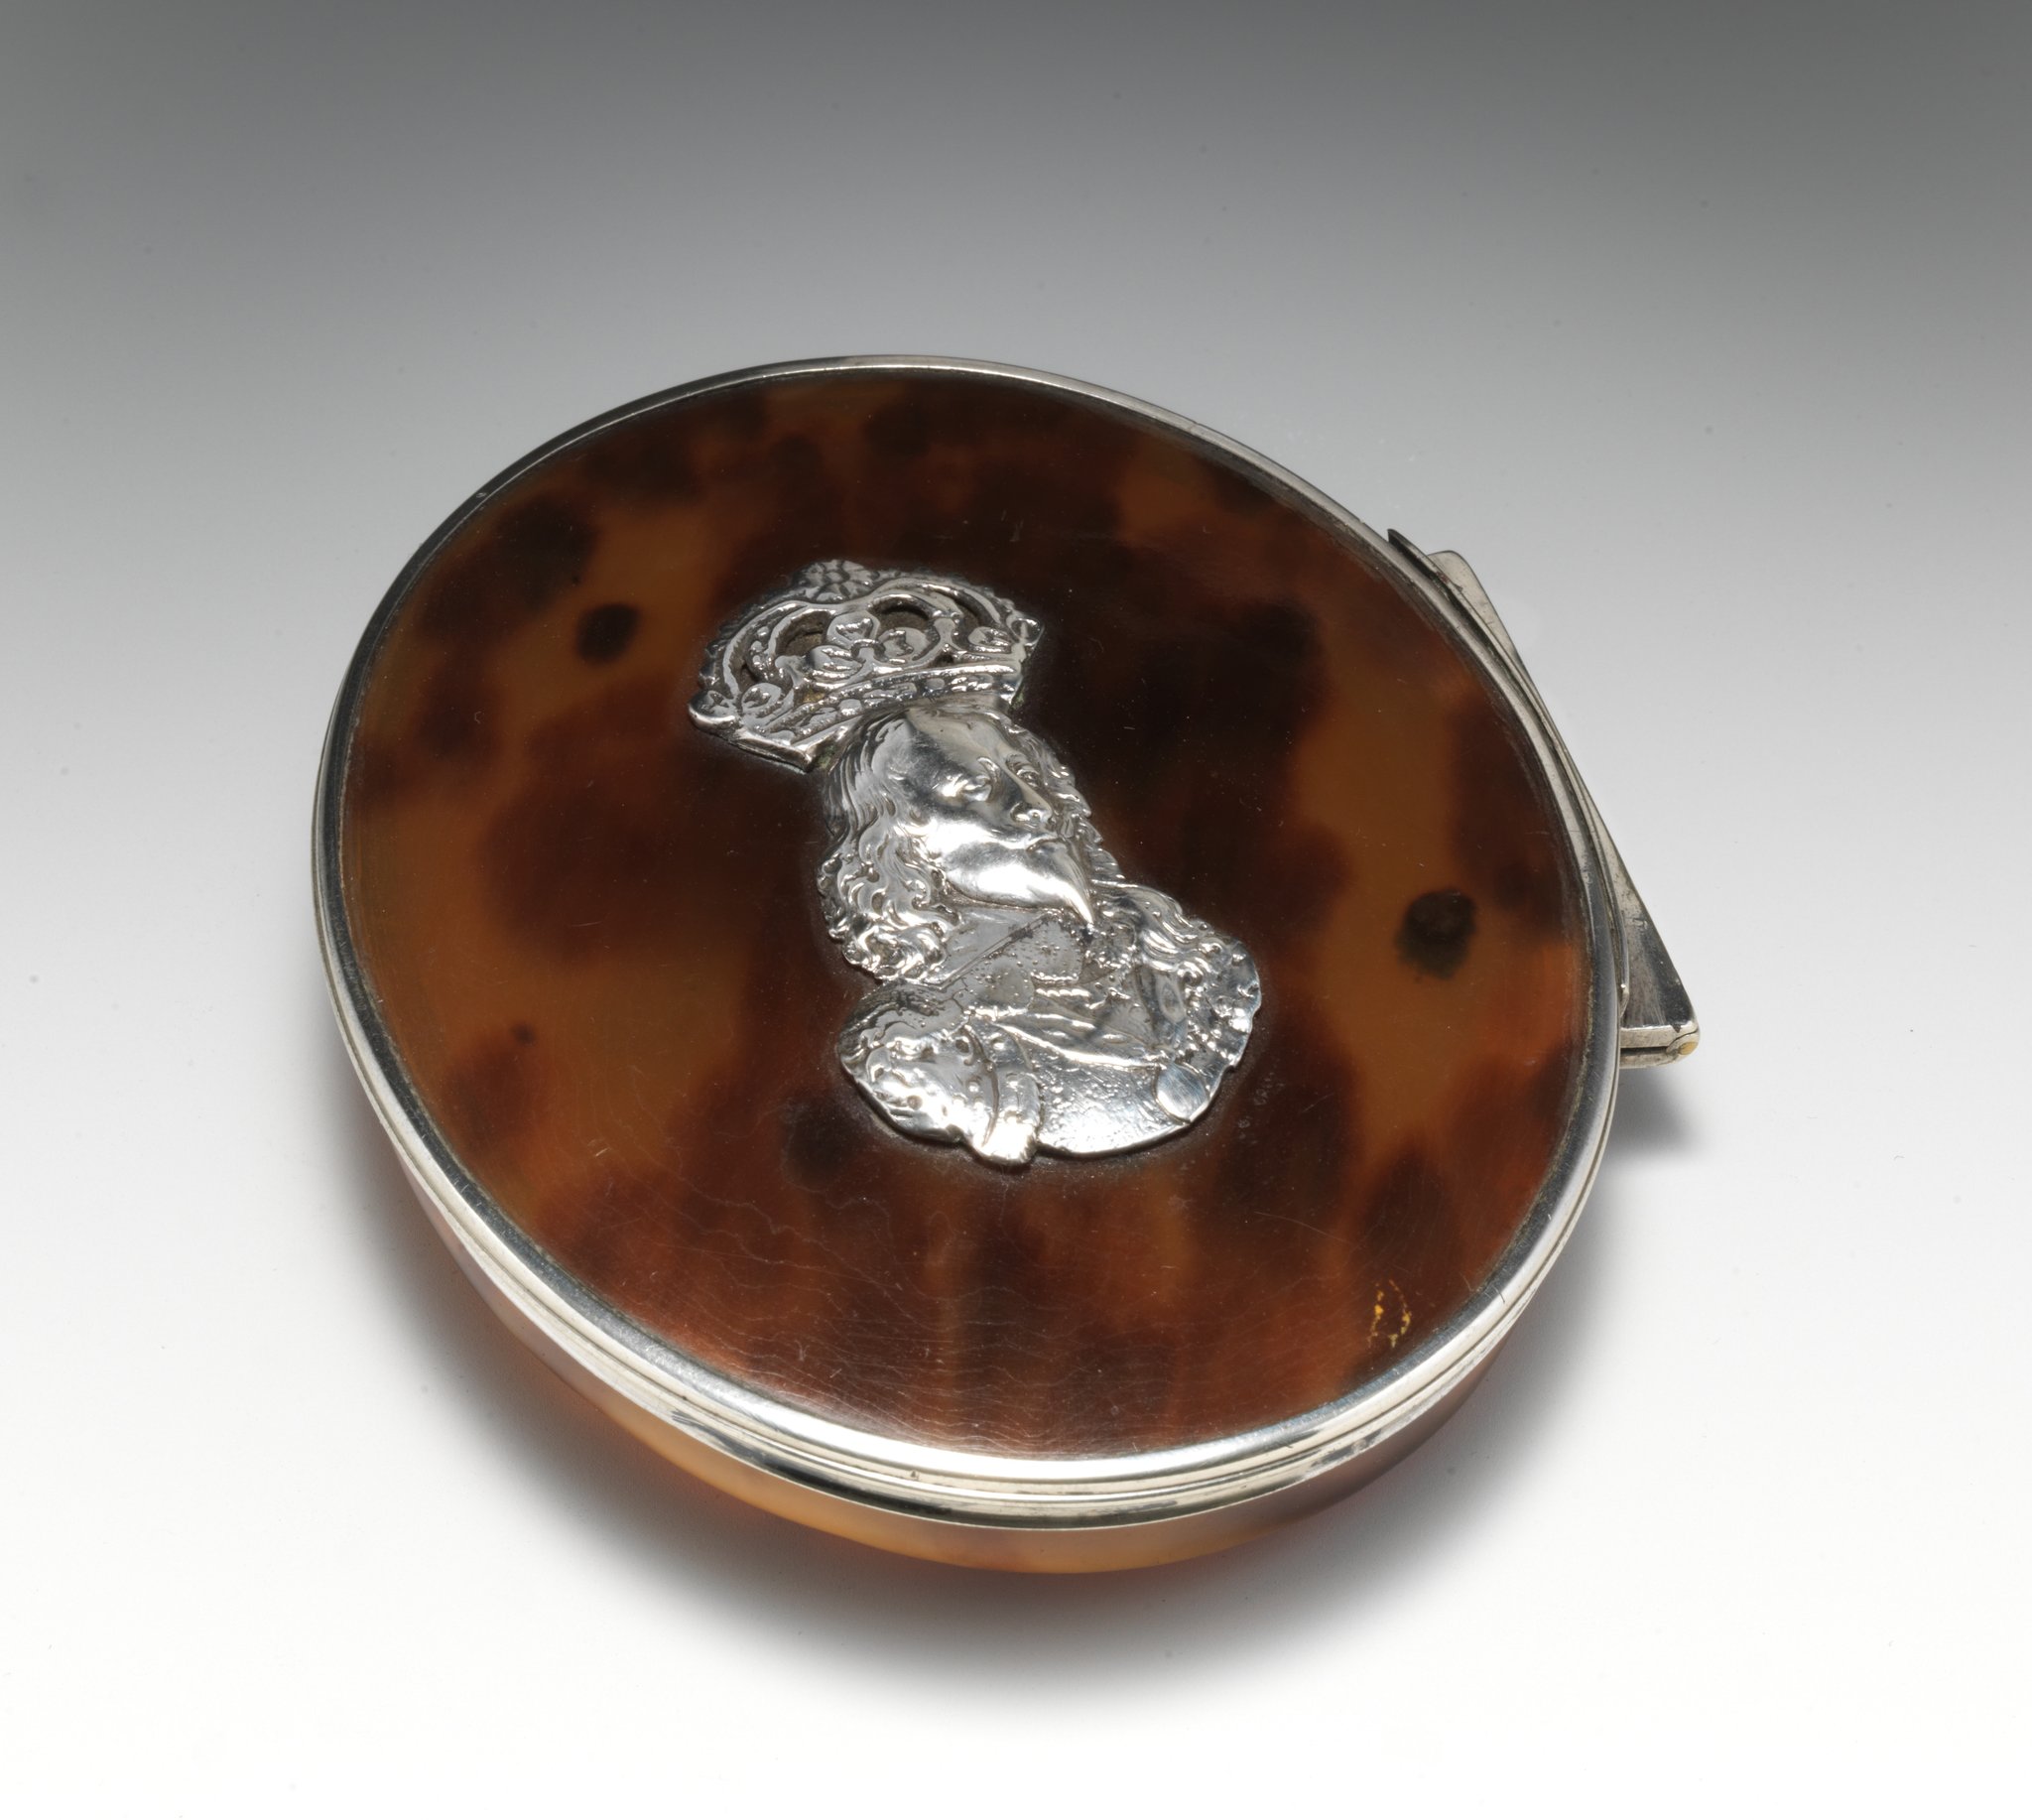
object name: tobacco box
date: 1601-1700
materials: silver, shell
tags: faces,men